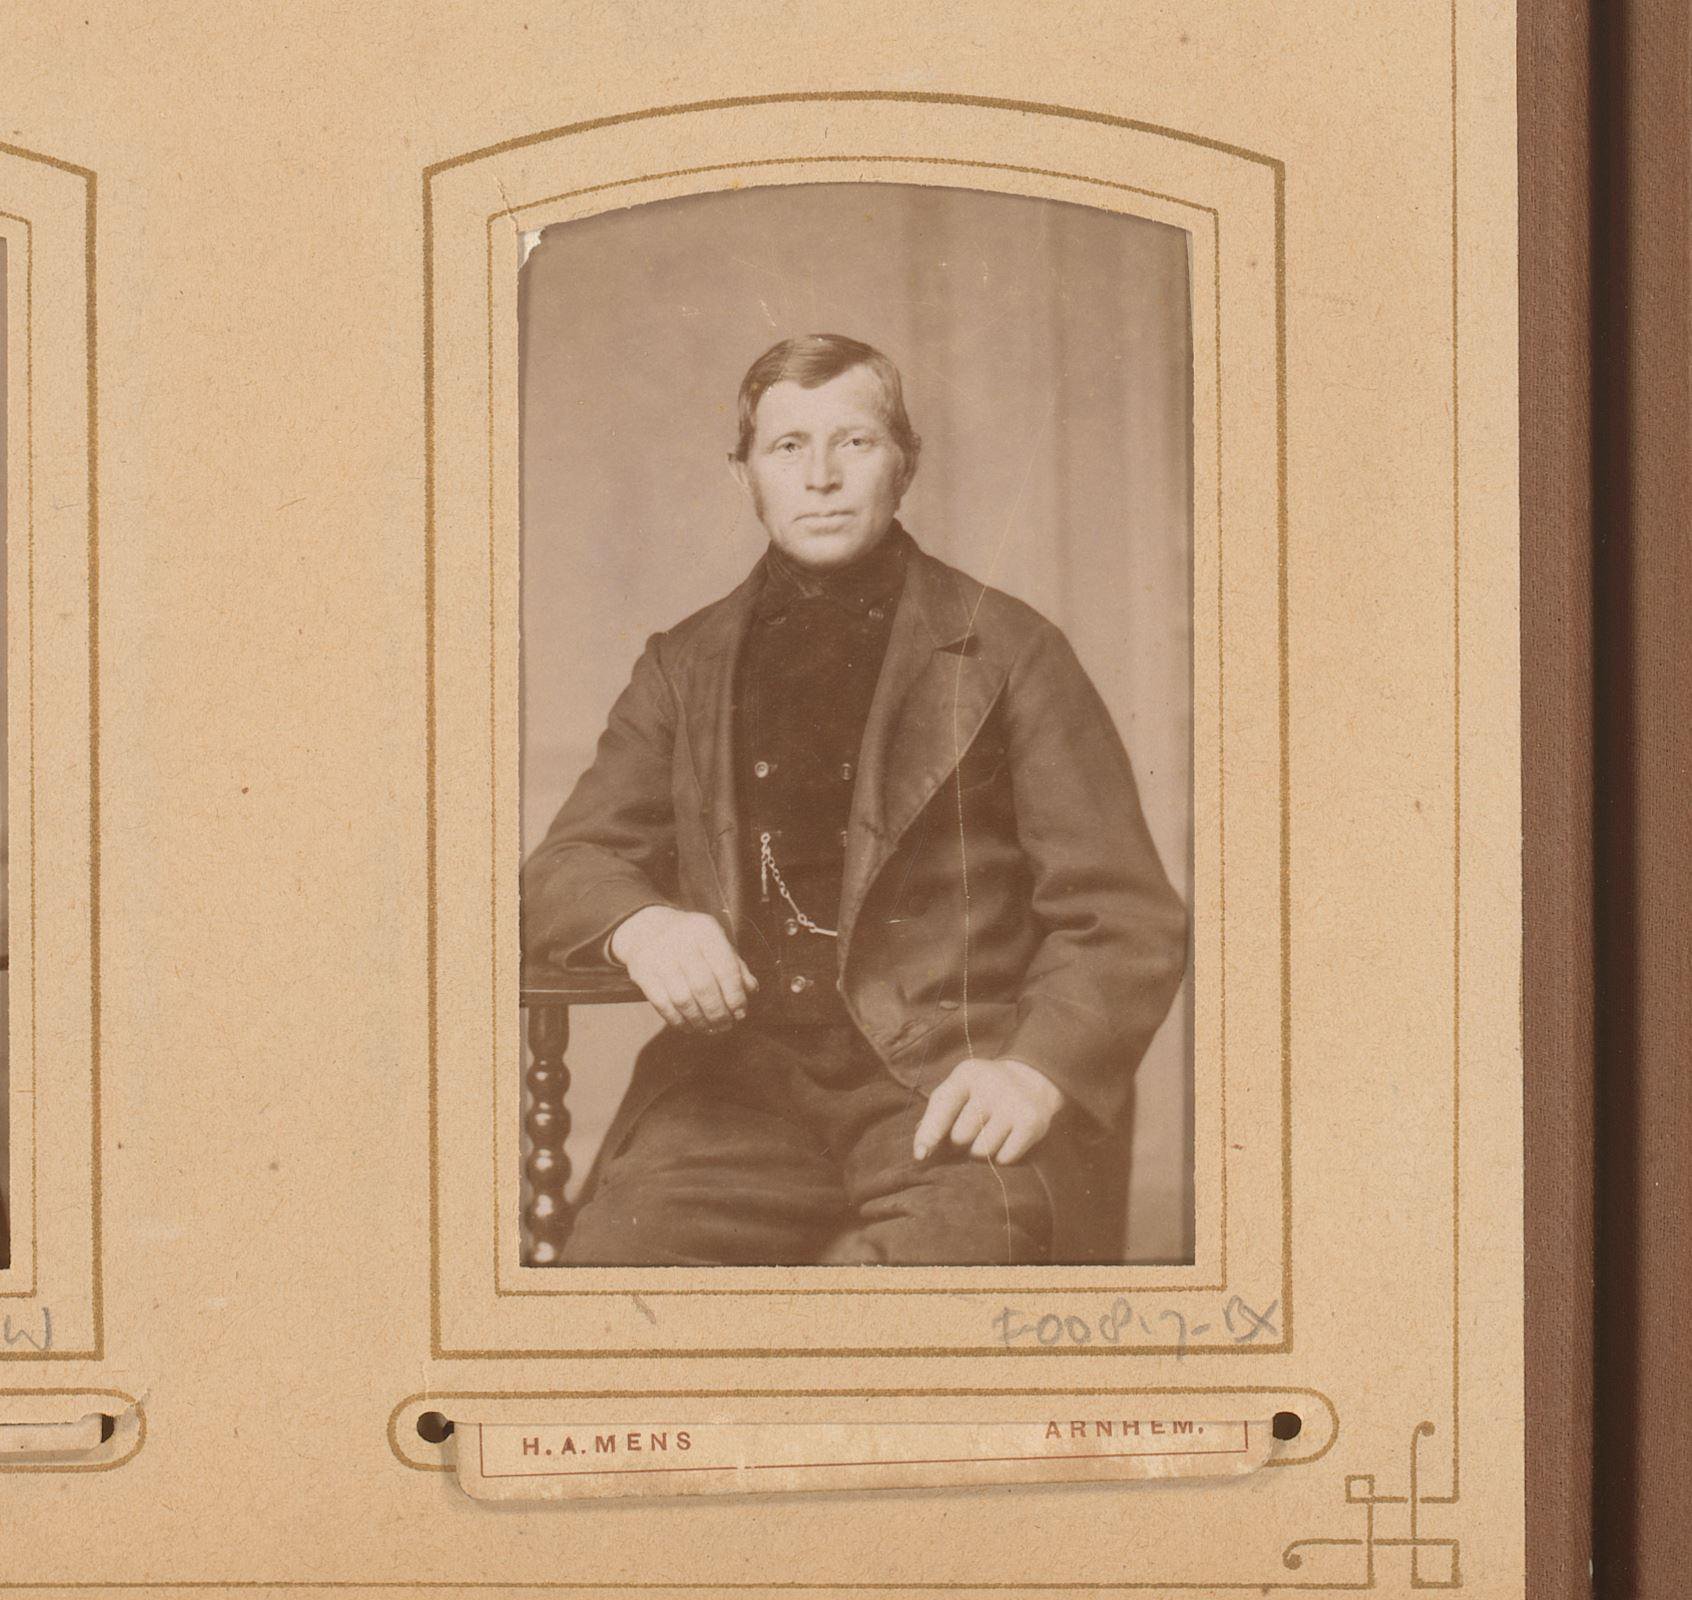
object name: photograph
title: Portret van een zittende man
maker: hermanus arnoldus mens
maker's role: fotograaf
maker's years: 1855-1926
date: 1870-1899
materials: cardboard, photographic support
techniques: albumen print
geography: arnhem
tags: historical persons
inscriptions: inscription: ‘Photographie van H.A. Mens/ Hommelstraat No 23/ Arnhem’